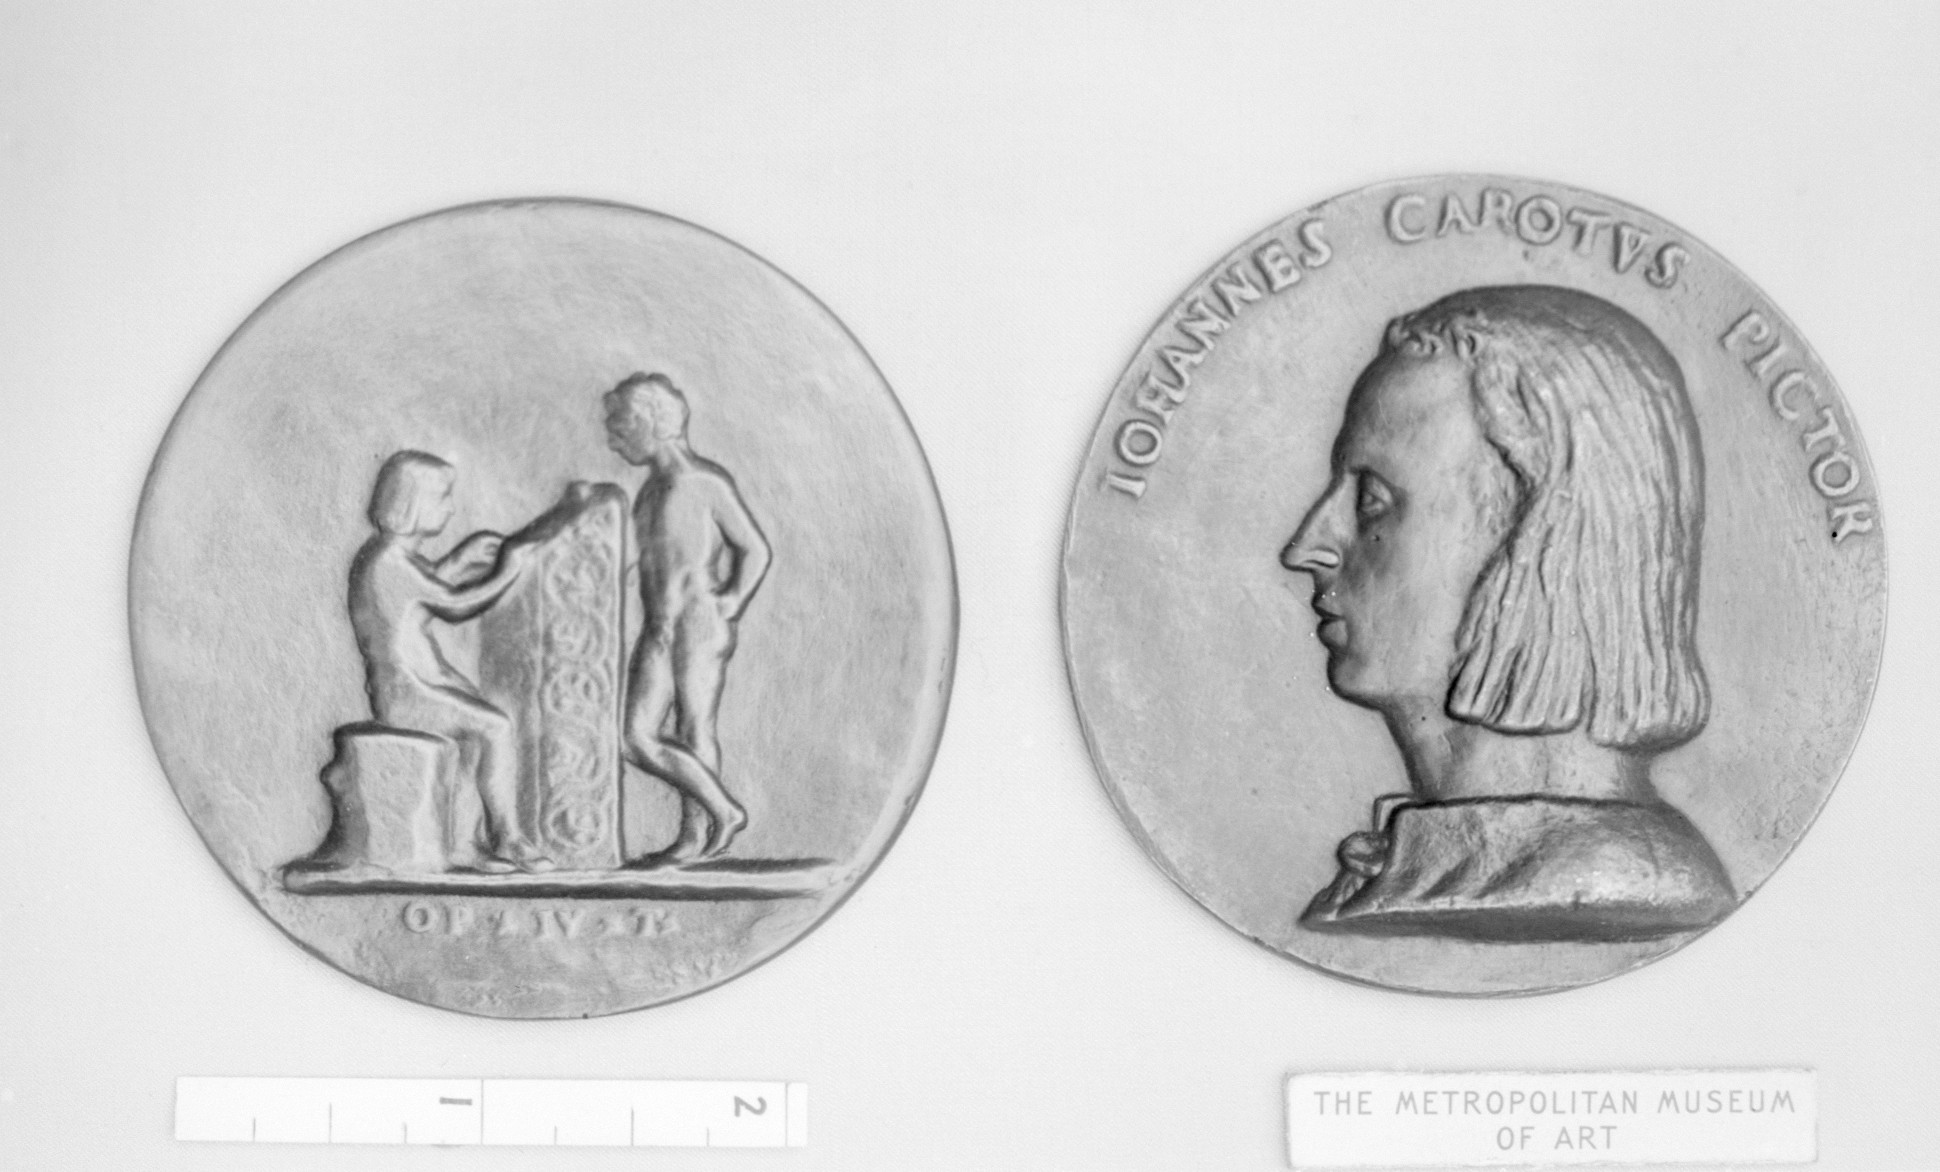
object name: medal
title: Giovanni Caroto (1495?–1555), Veronese Painter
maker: giulio della torre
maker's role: artist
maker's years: 1481-1562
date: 1501-1600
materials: bronze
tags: men,male nudes,profiles,female nudes